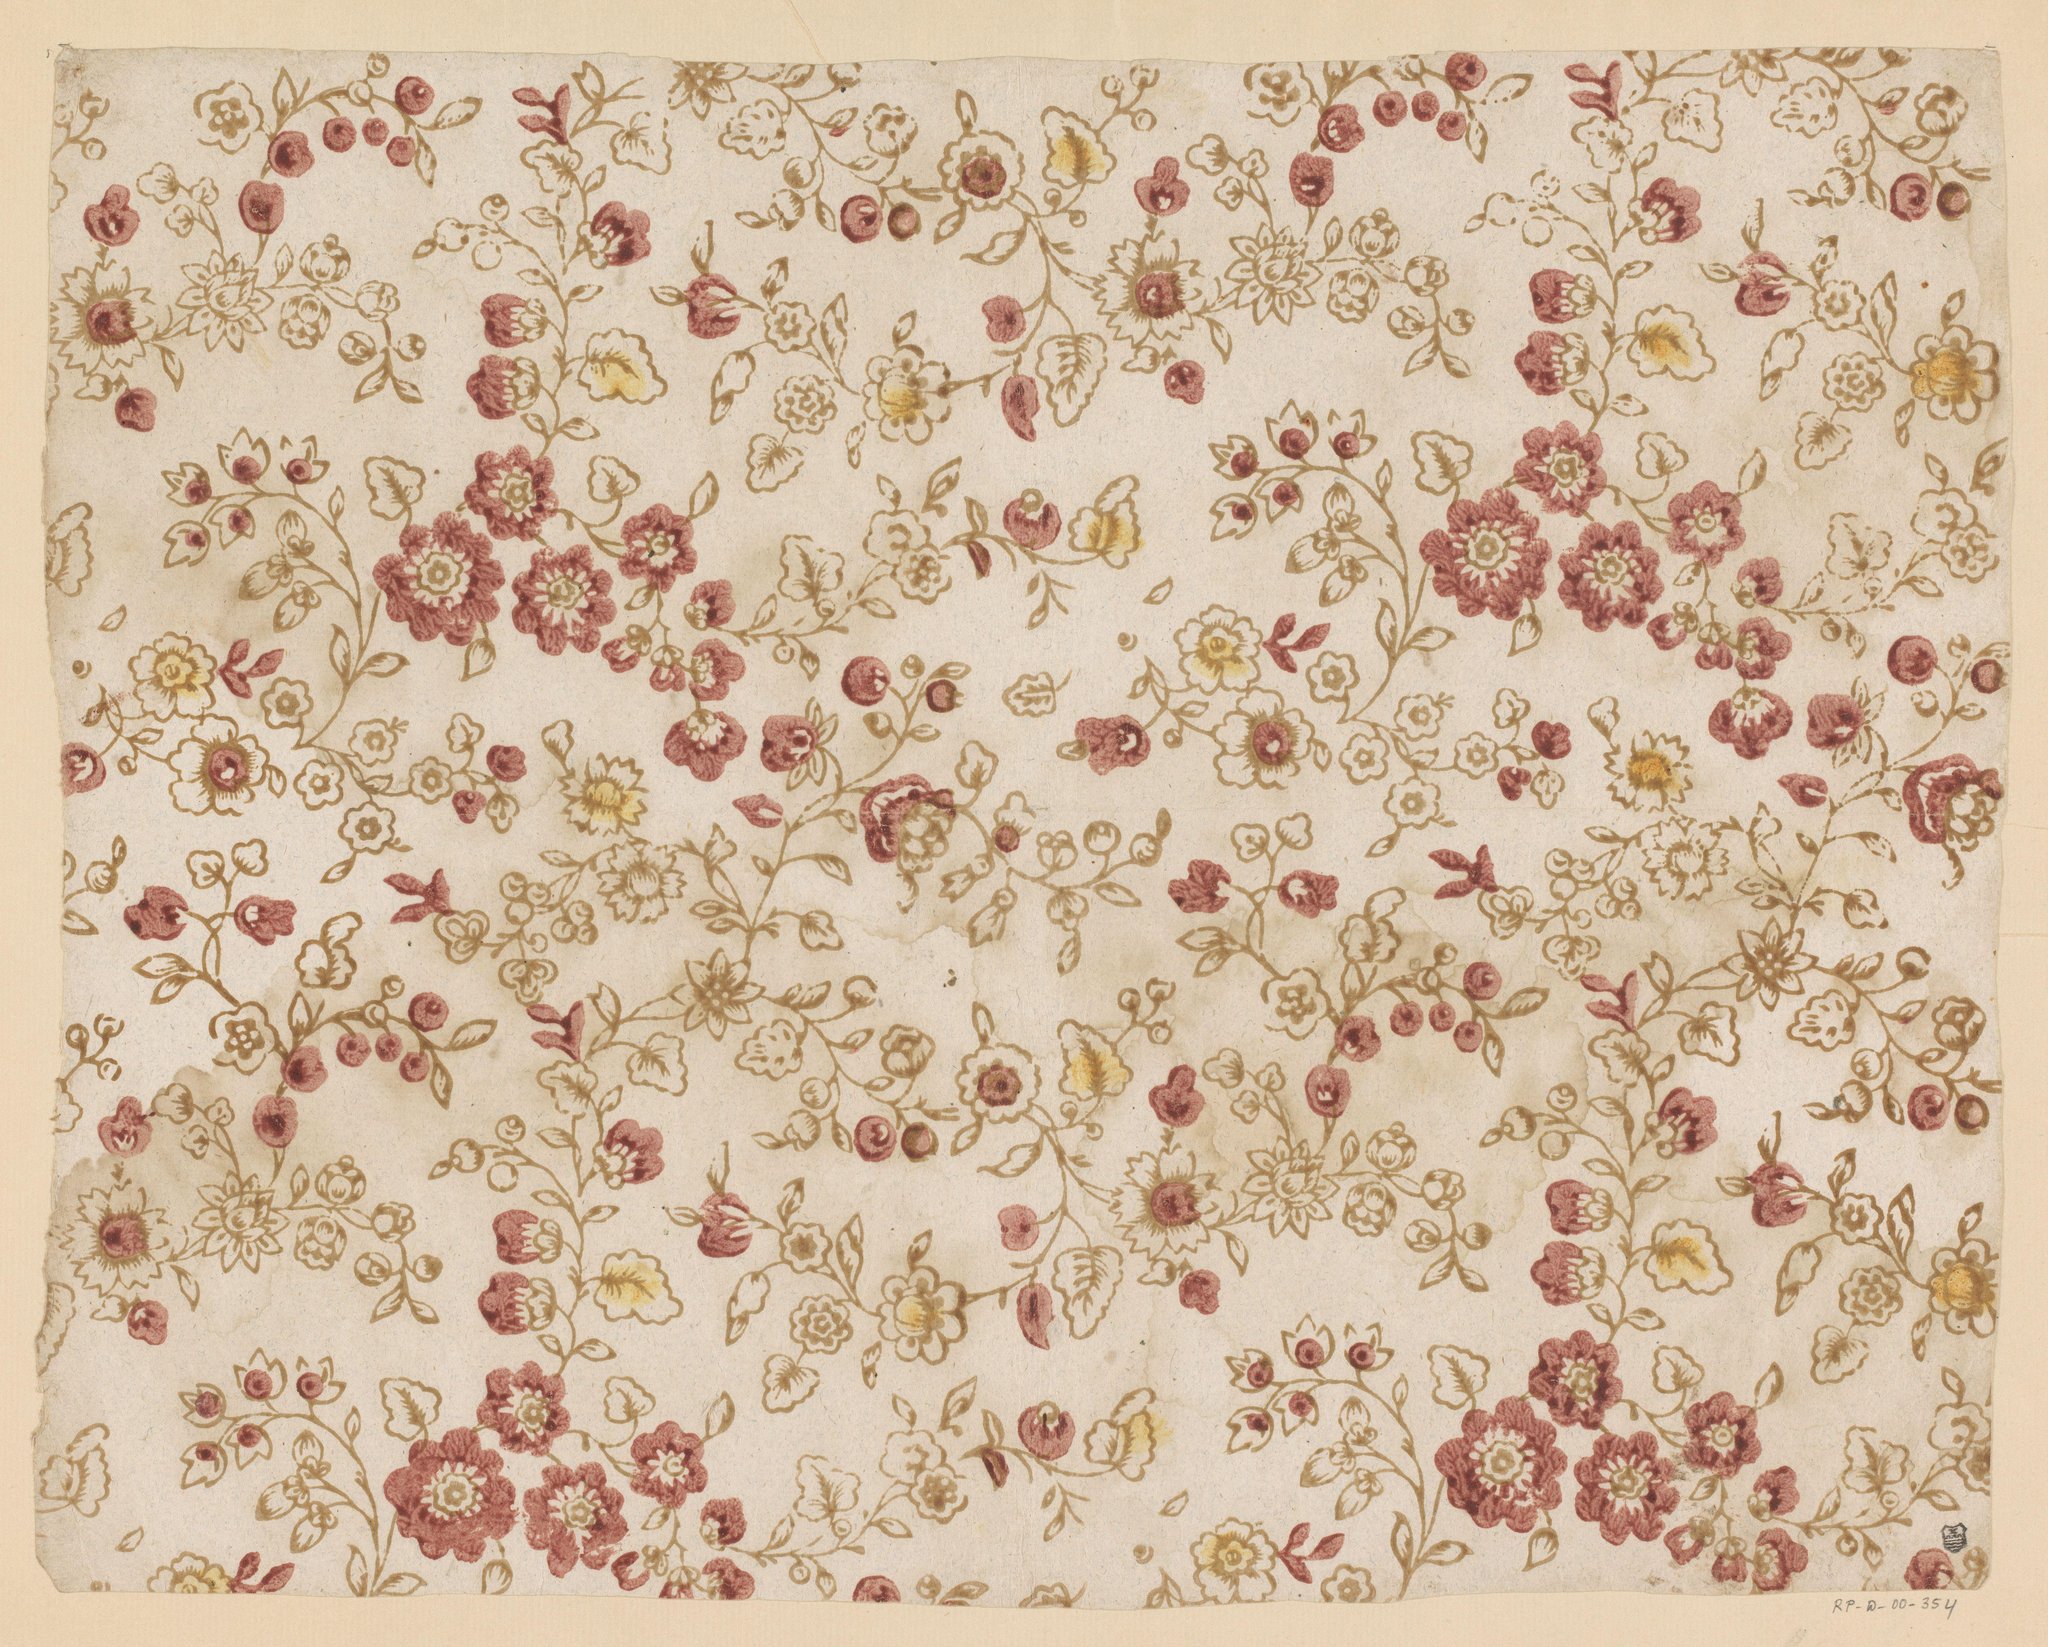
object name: printed paper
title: Blad met ranken met bloemen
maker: Anonymous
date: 1700-1800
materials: paper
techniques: printing block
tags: ornament derived from plant forms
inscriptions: collector's mark: Lugt 2760